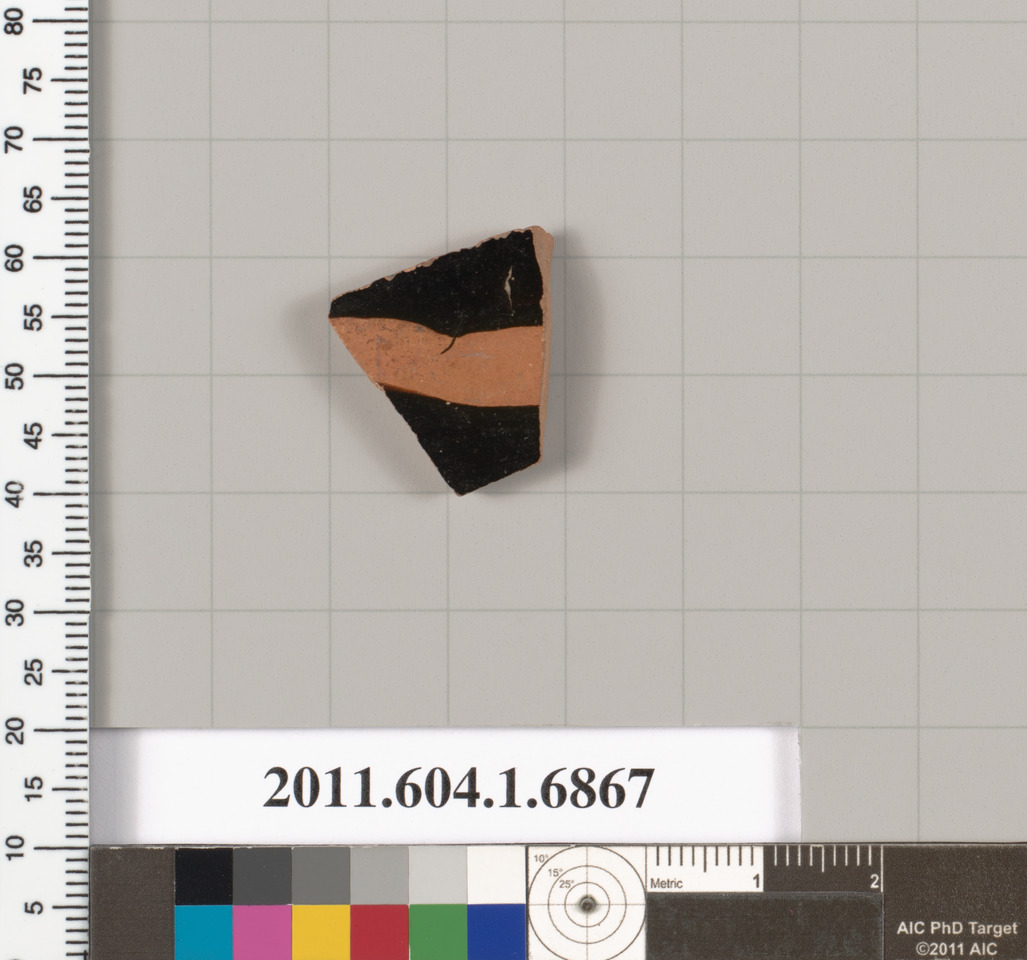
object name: kylix fragment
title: Terracotta fragment of a kylix (drinking cup)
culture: greek, attic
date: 490-470 BCE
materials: terracotta